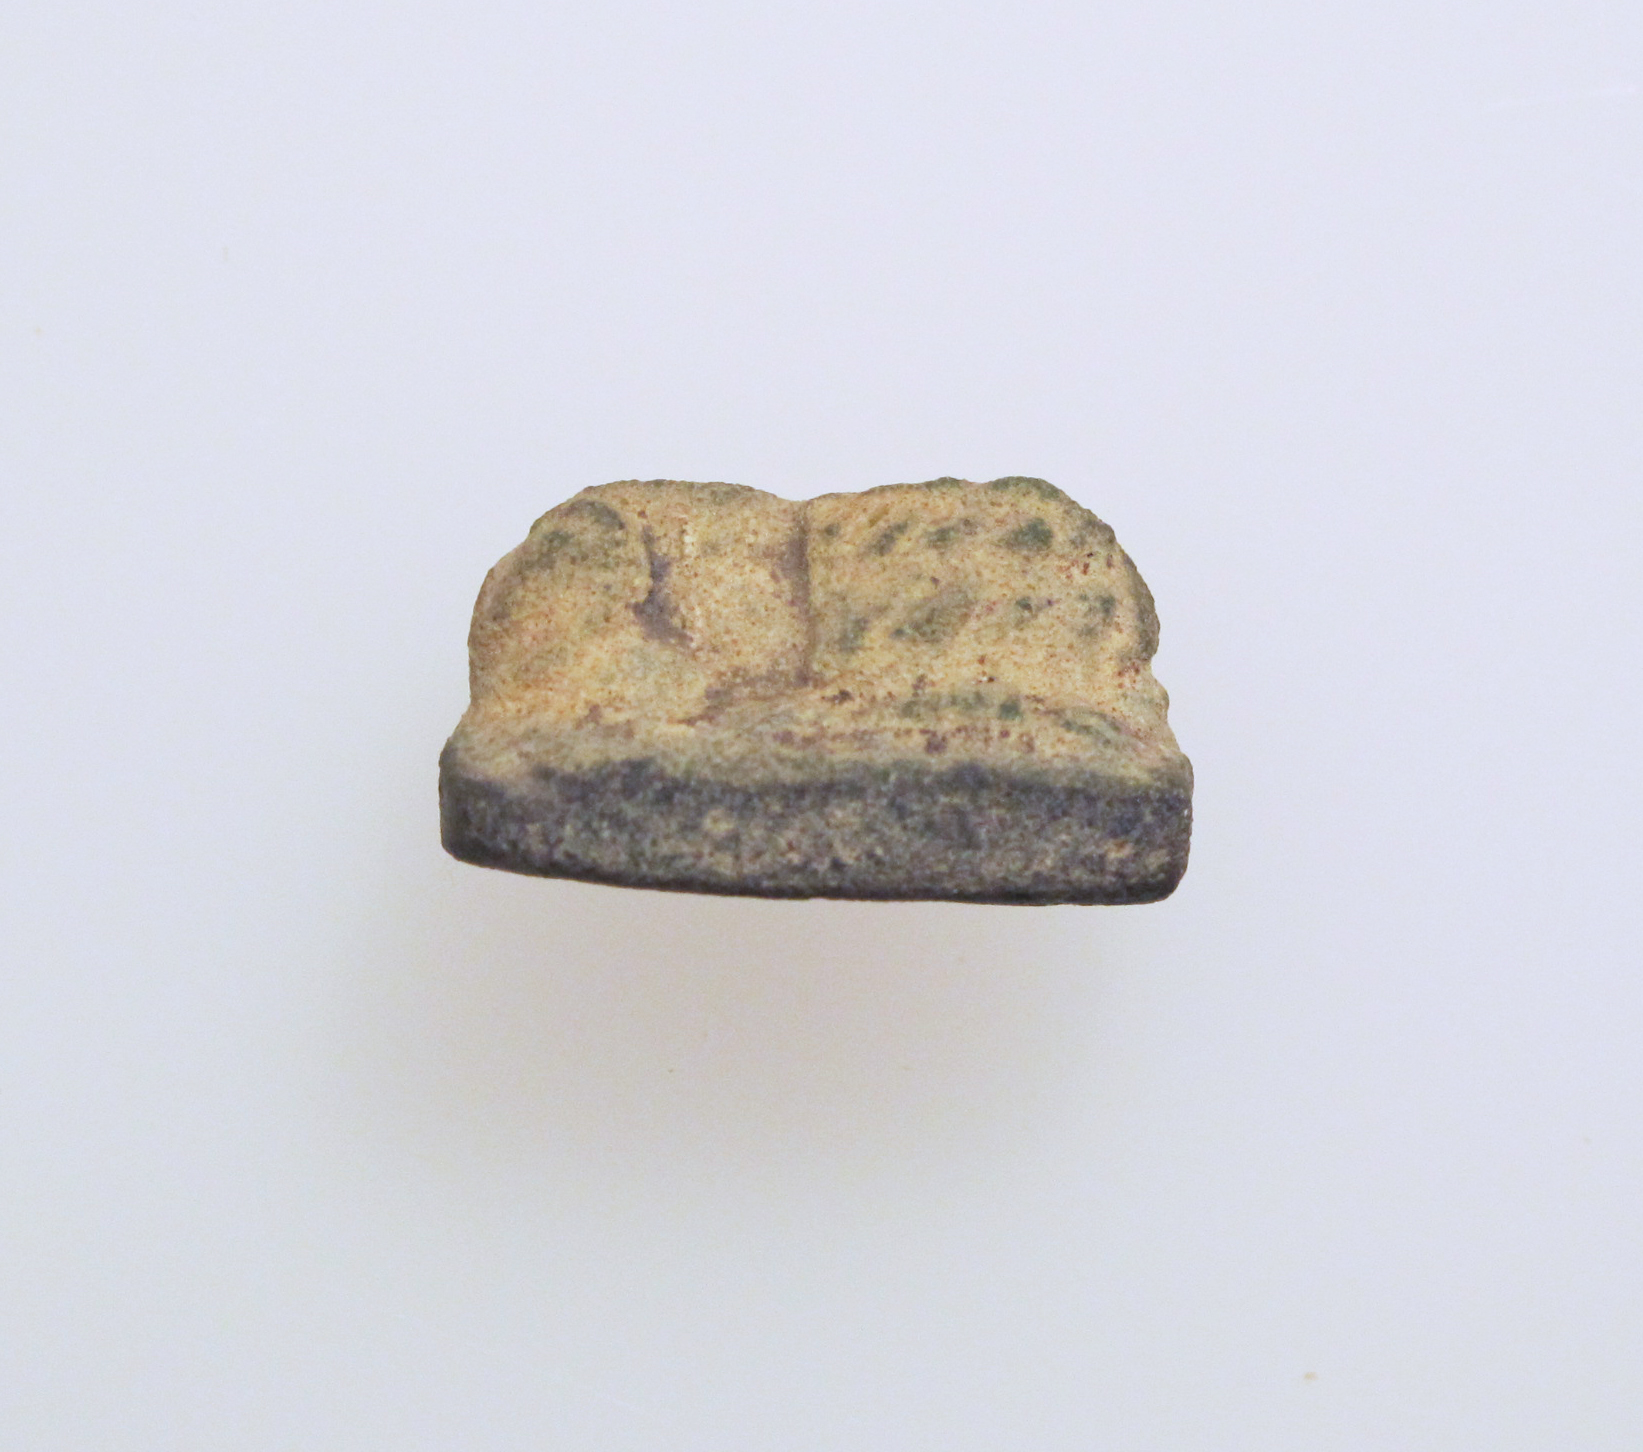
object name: ornament, lion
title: Ornament in the form of a lion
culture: roman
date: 670 BCE-330 CE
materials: glass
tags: lions